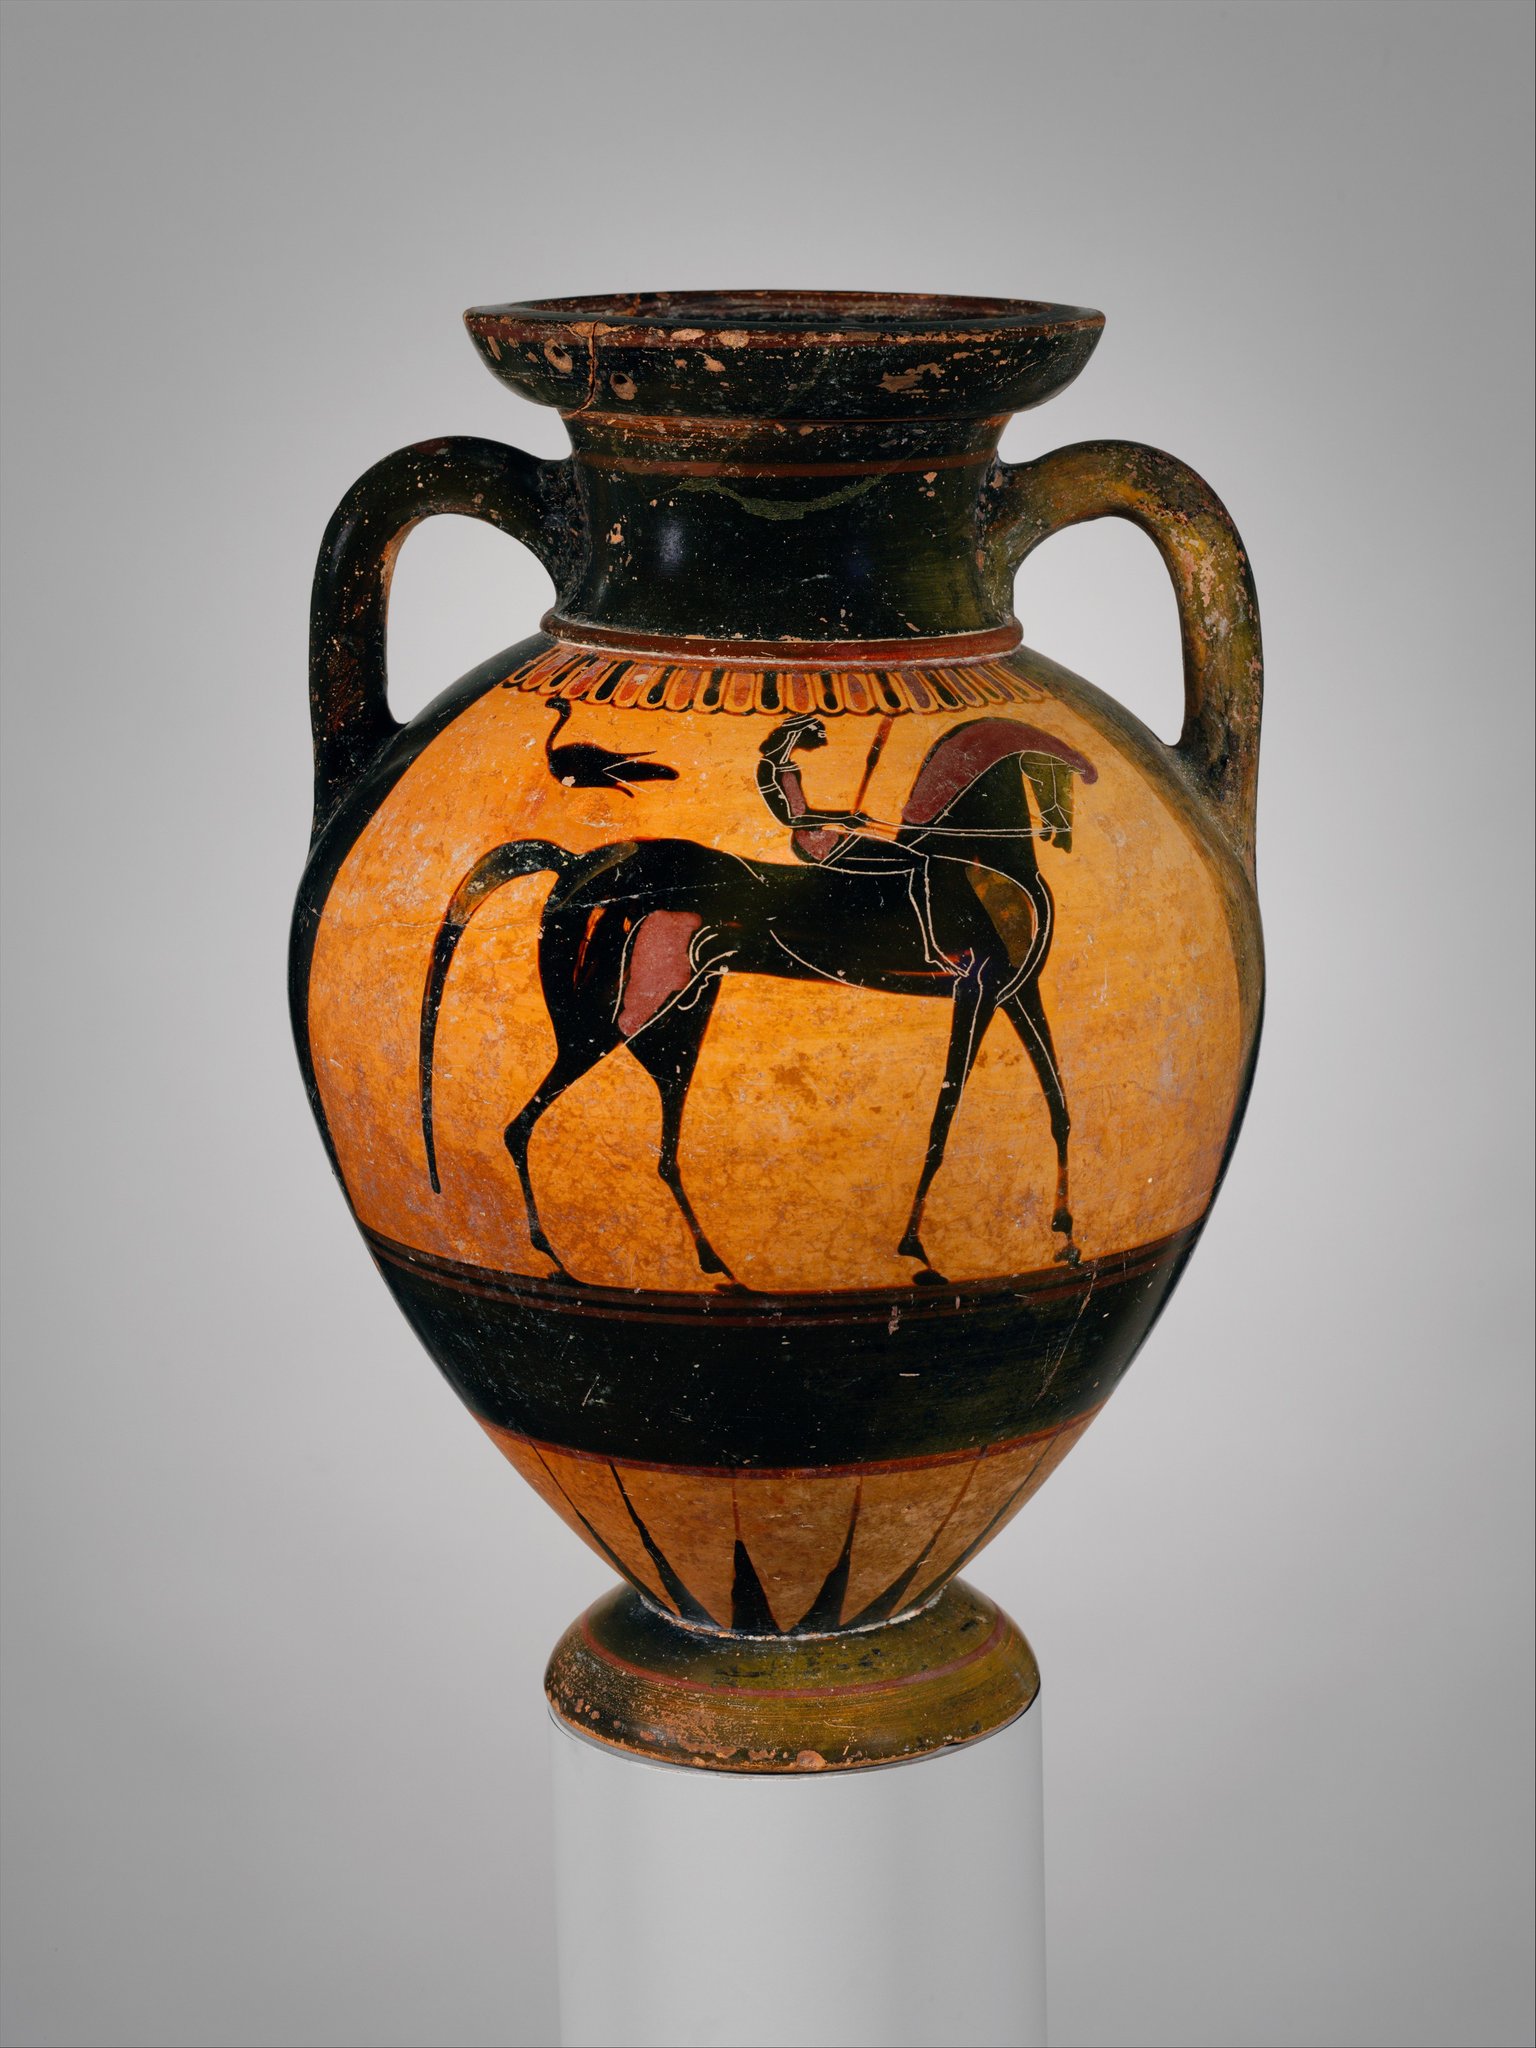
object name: neck amphora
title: Terracotta neck-amphora (jar)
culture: greek, attic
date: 560-550 BCE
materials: terracotta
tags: birds,horses